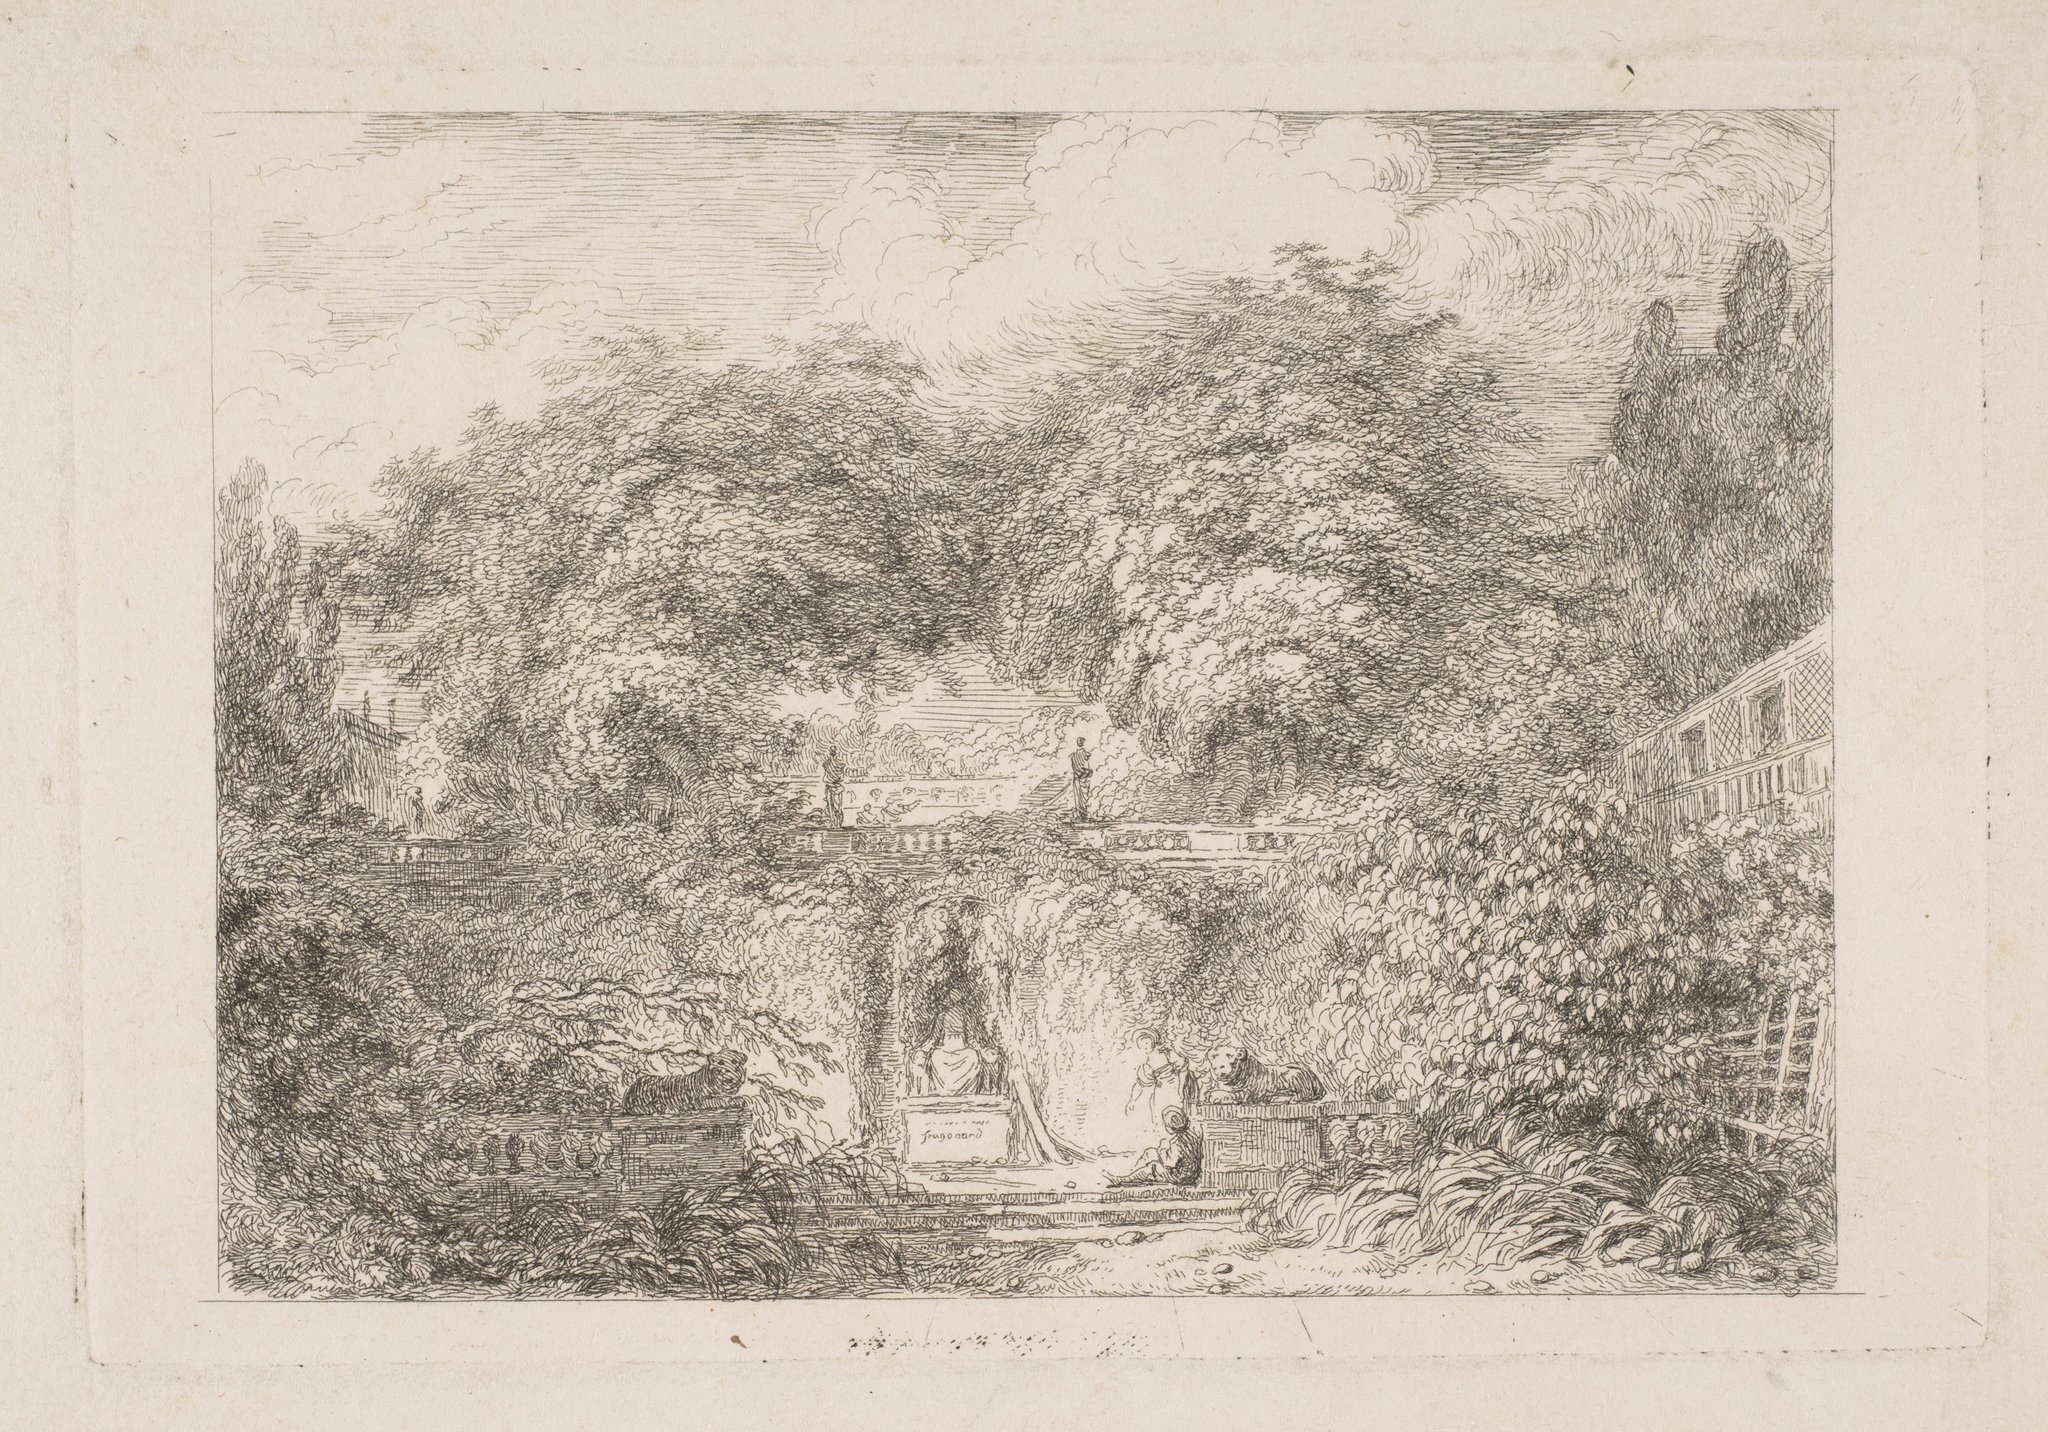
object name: print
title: The Little Park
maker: jean honoré fragonard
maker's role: artist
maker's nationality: french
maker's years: 1732-1806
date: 1763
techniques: etching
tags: parks